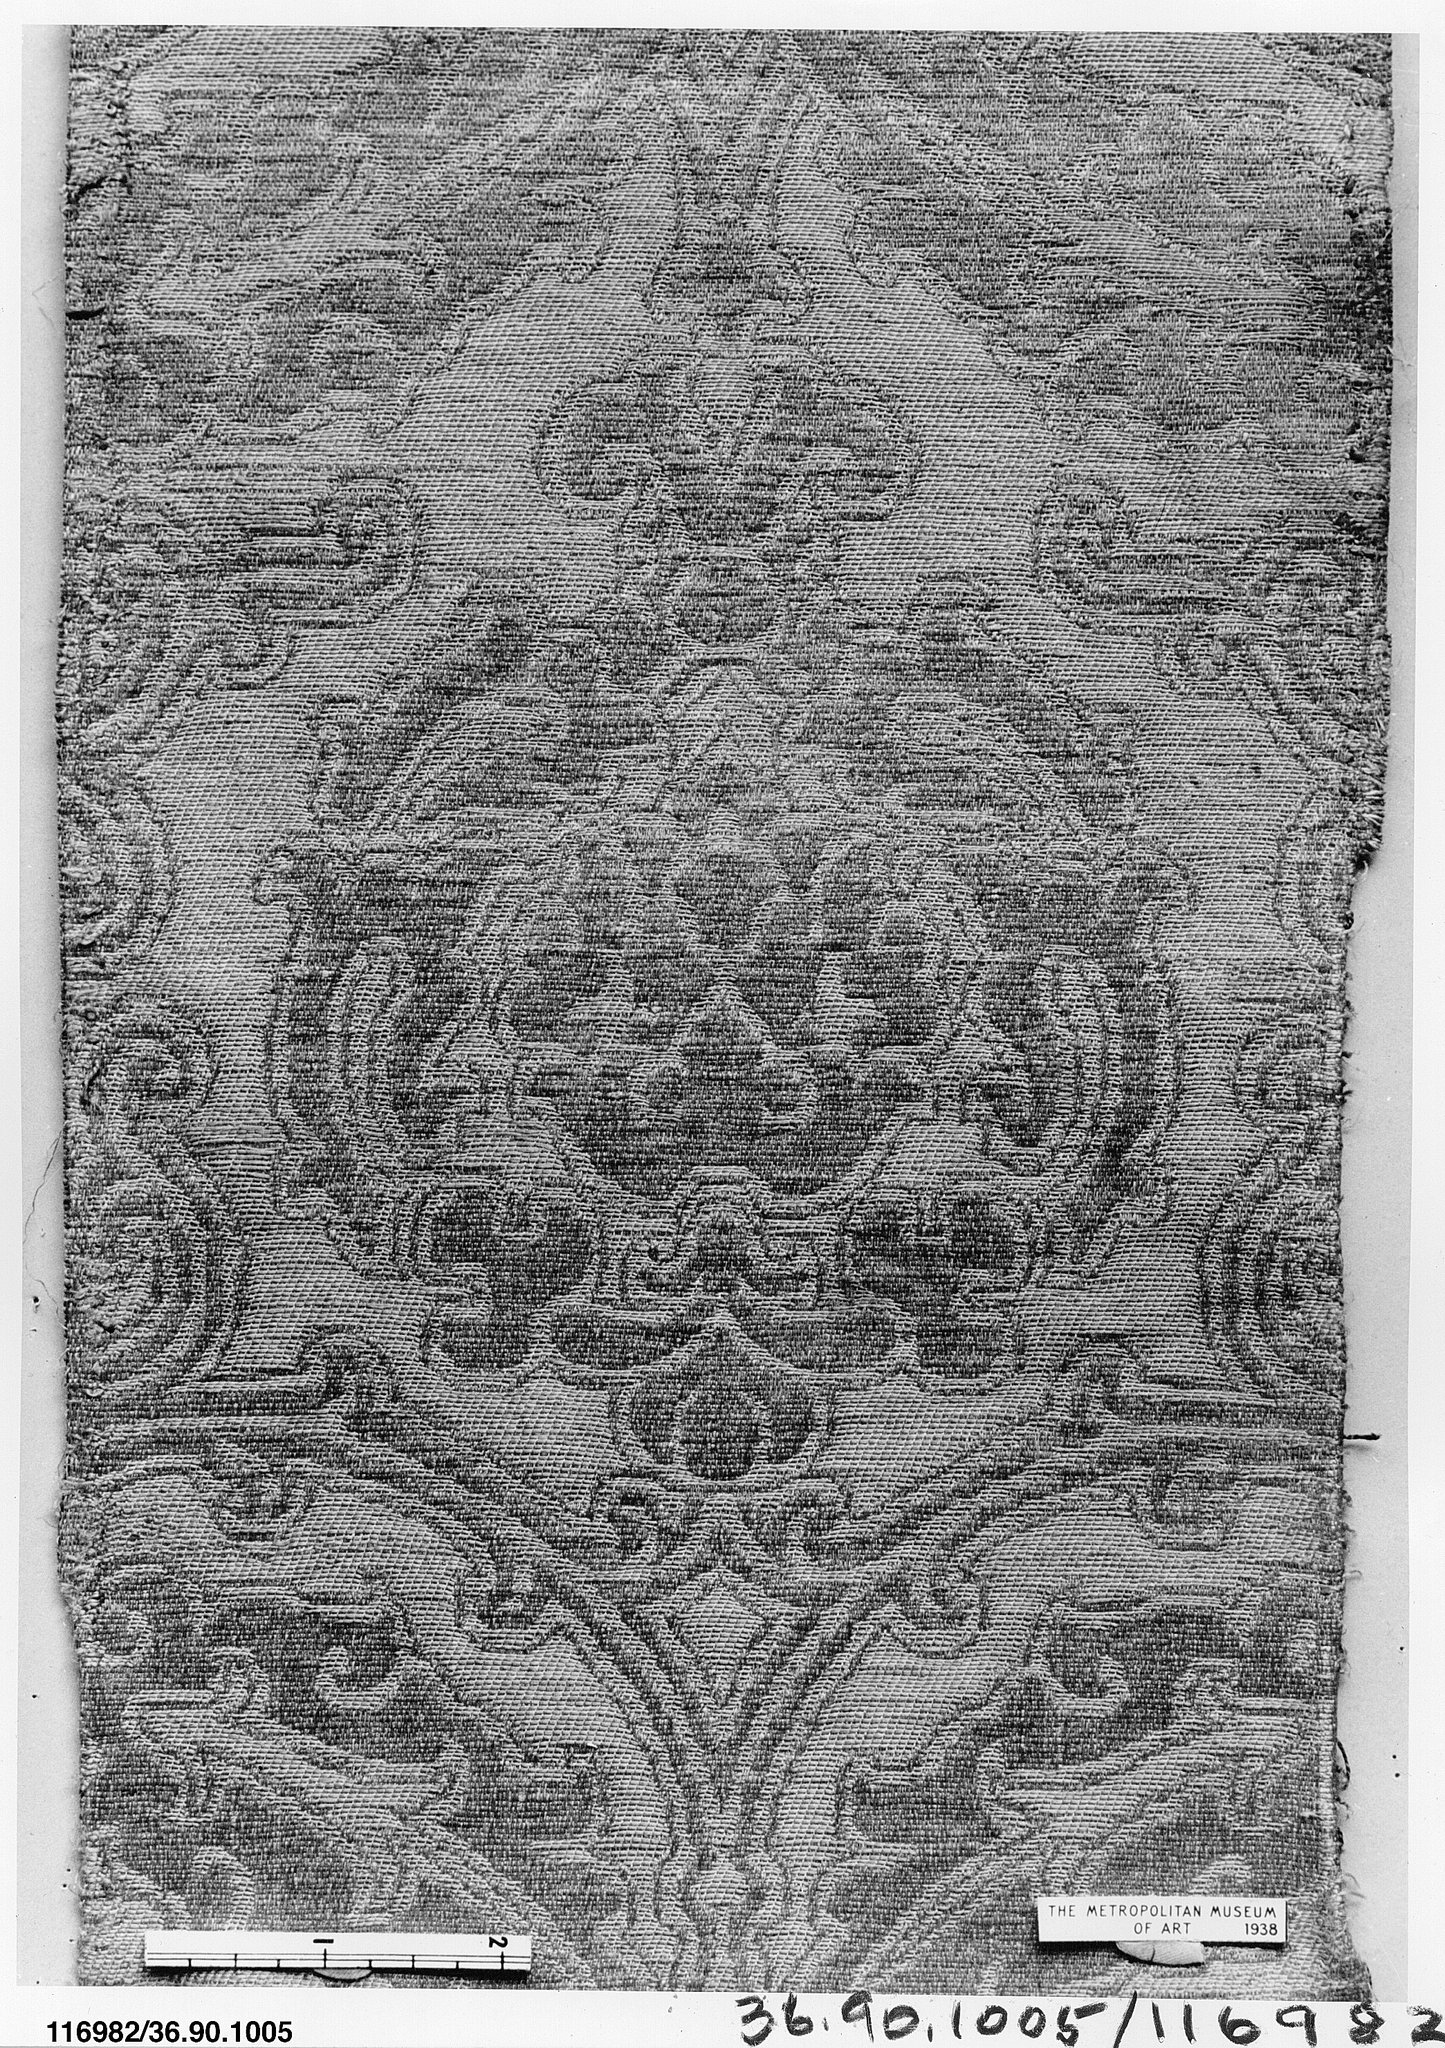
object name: piece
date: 1501-1600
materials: cotton, silk